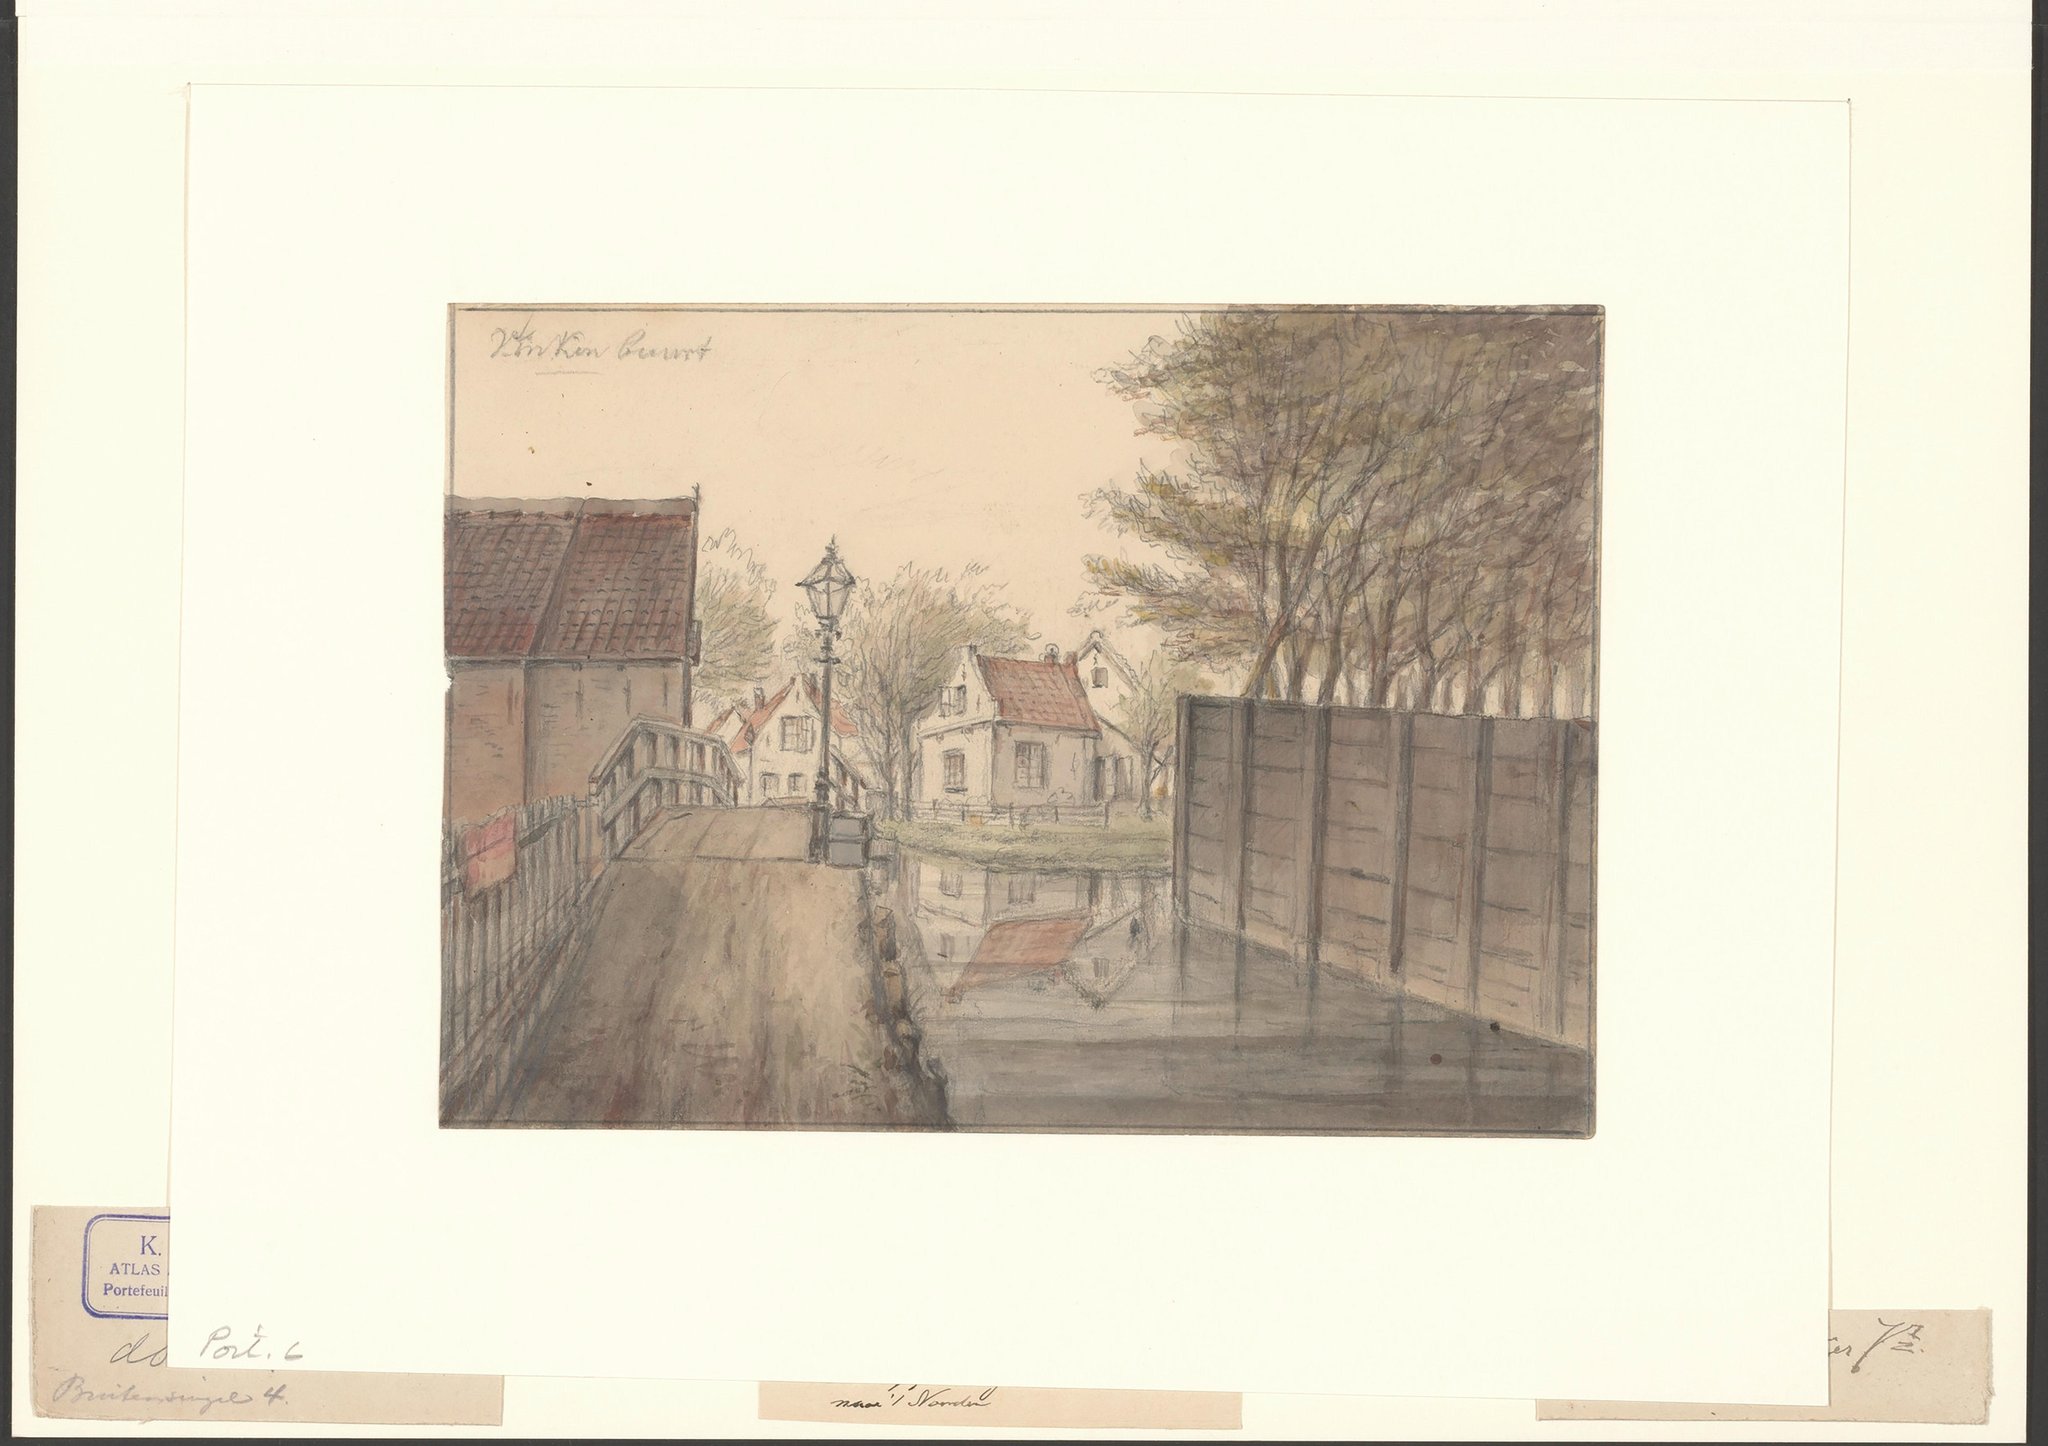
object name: drawing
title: Gezicht op het Vinkenbuurtpad achter begraafplaats De Liefde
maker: albert martin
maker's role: draughtsman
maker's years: 1827-1900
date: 1837-1900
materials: paper, pencil, watercolor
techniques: brush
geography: amsterdam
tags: city-view in general; 'veduta', road, path, small canal, ditch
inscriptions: inscription: ‘Port. 6’, inscription: ‘achter het kerkhof (...) naar 't Noorden’, inscription: ‘door A. Martin / Buitensingel 4 / Atlas D.C. Meijer Jr’, collector's mark: ‘6’ Lugt 1641b, inscription: ‘Vinken buurt’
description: Onderwerpsrubriek binnen de Atlas Amsterdam: Buijskade, Catskade (Jacob), Clercqstraat (de), Commelinstraat, Costakade (da), Cuypstraat (Albert), Czaar Peterstraat.